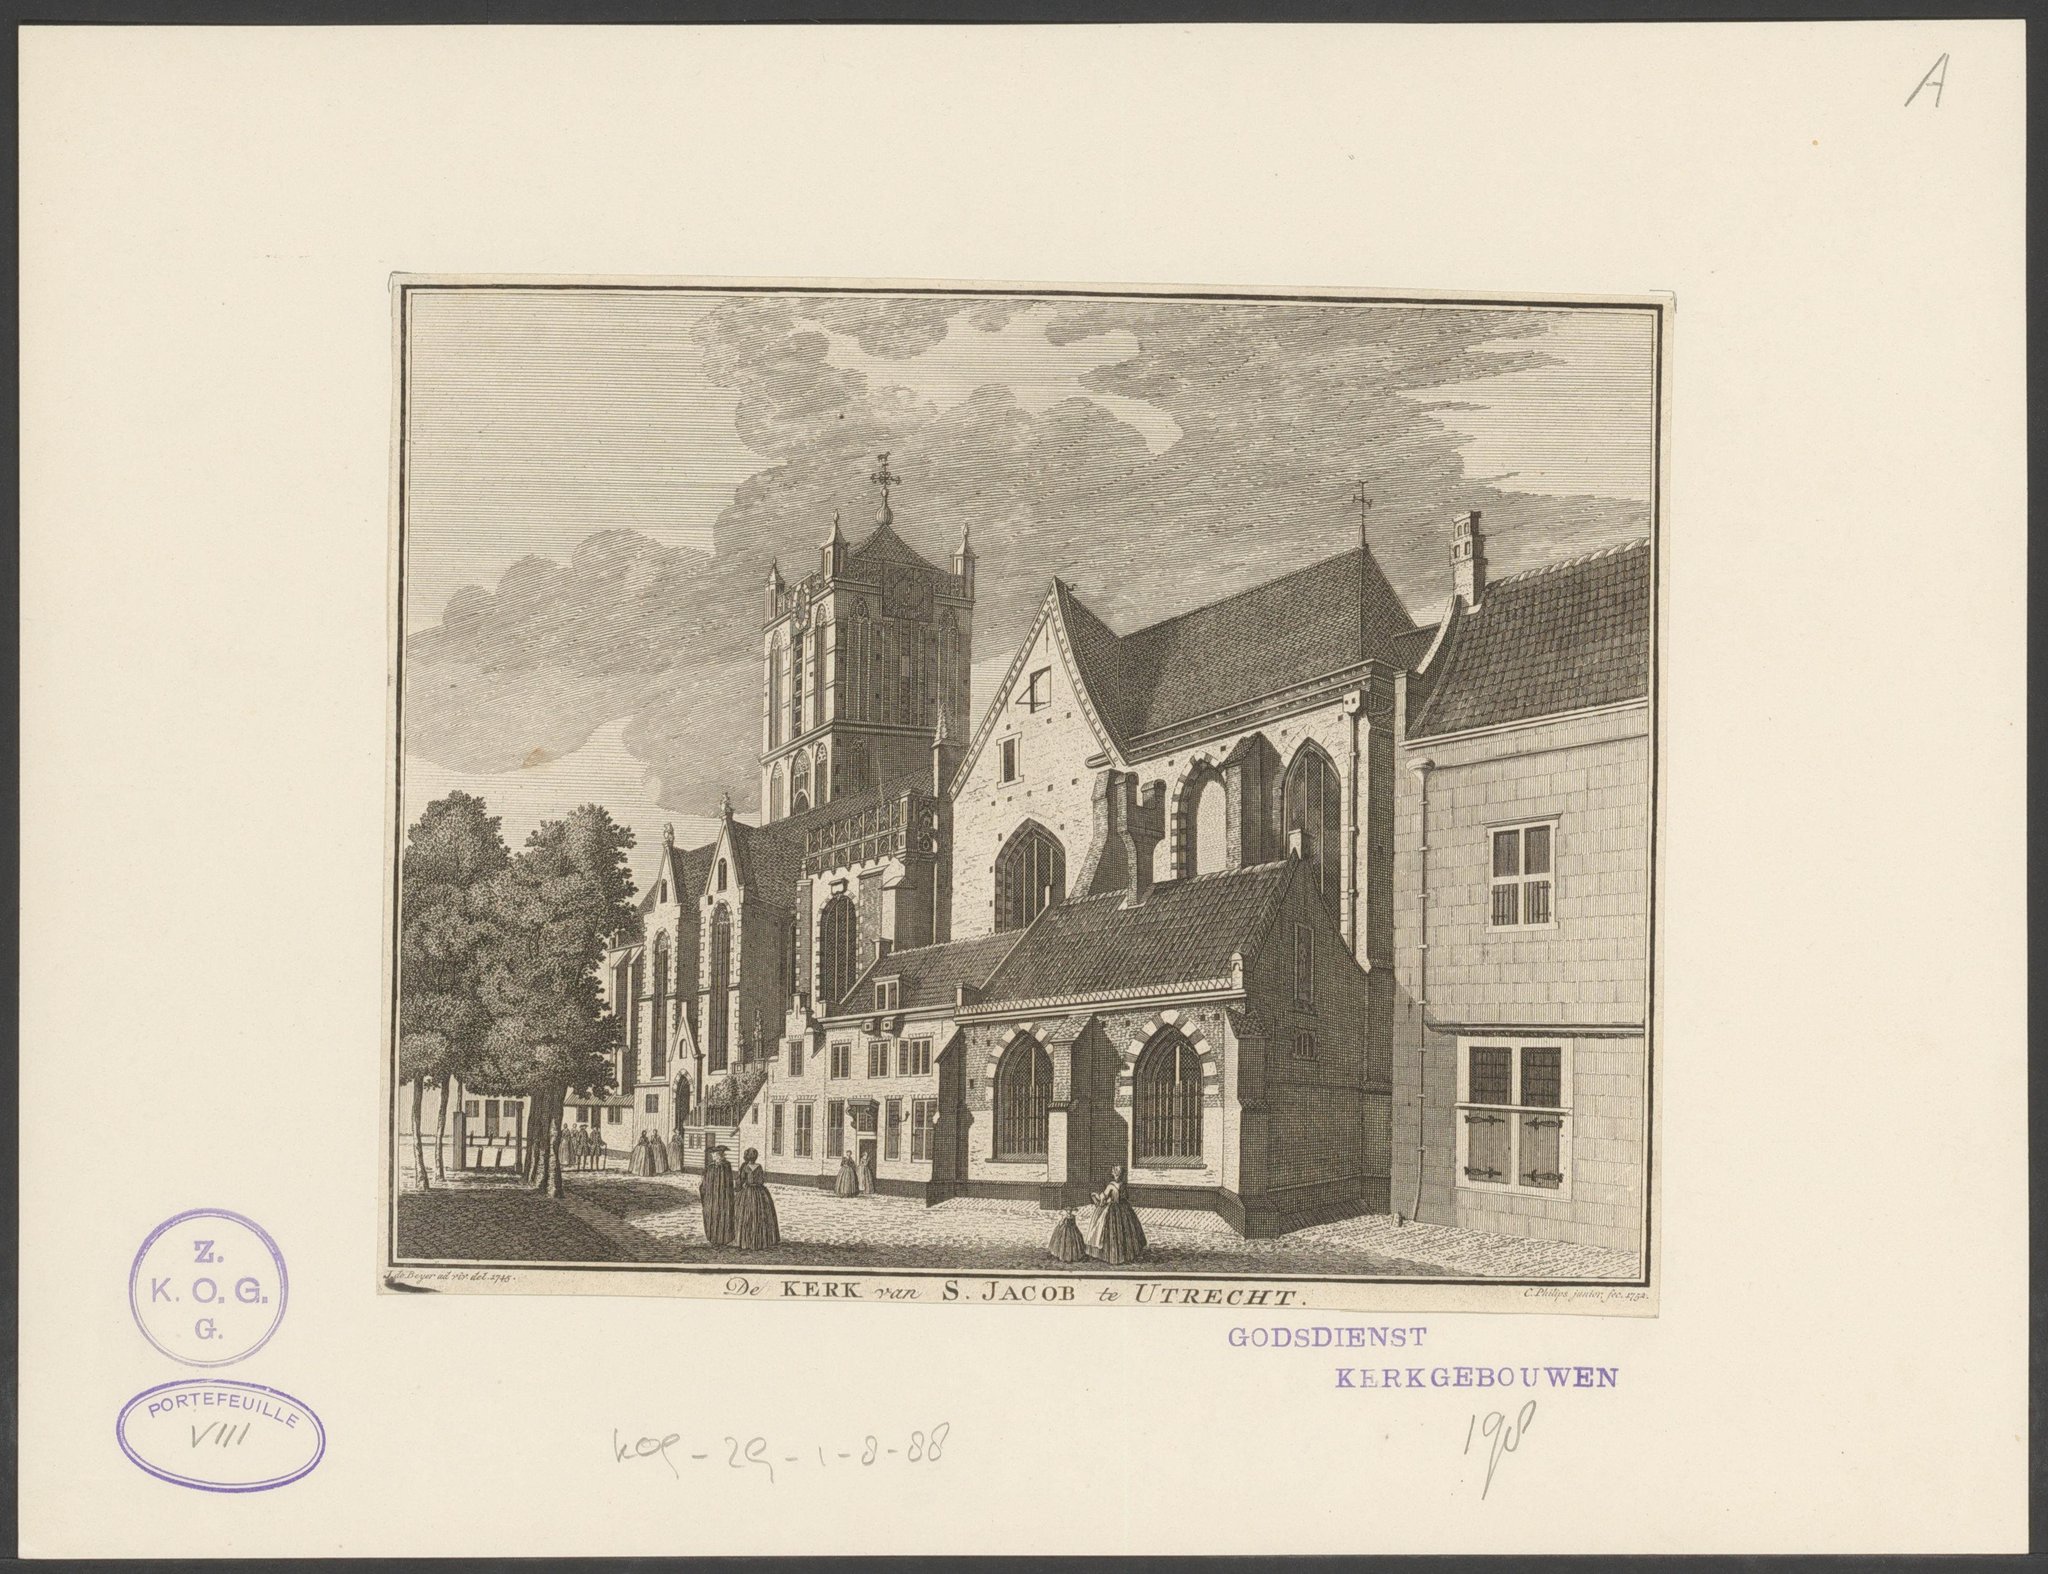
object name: book illustration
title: De kerk van S. Jacob te Utrecht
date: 1752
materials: paper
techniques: etching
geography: amsterdam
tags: church (exterior), street (+ city(-scape) with figures, staffage)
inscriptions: collector's mark: Lugt 1641, collector's mark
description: Prent ook gebruikt in: Tegenwoordige staat der Vereenigde Nederlanden, elfde deel, behelzende eene beschryving van de provincie van Utrecht. Met landkaarten, plans der steden en printverbeeldingen versierd / Hedendaagsche historie, of tegenwoordige staat van alle volkeren; XXI. deel (…). Amsterdam: Isaak Tirion, 1758, tussen p. 374 en p. 375.